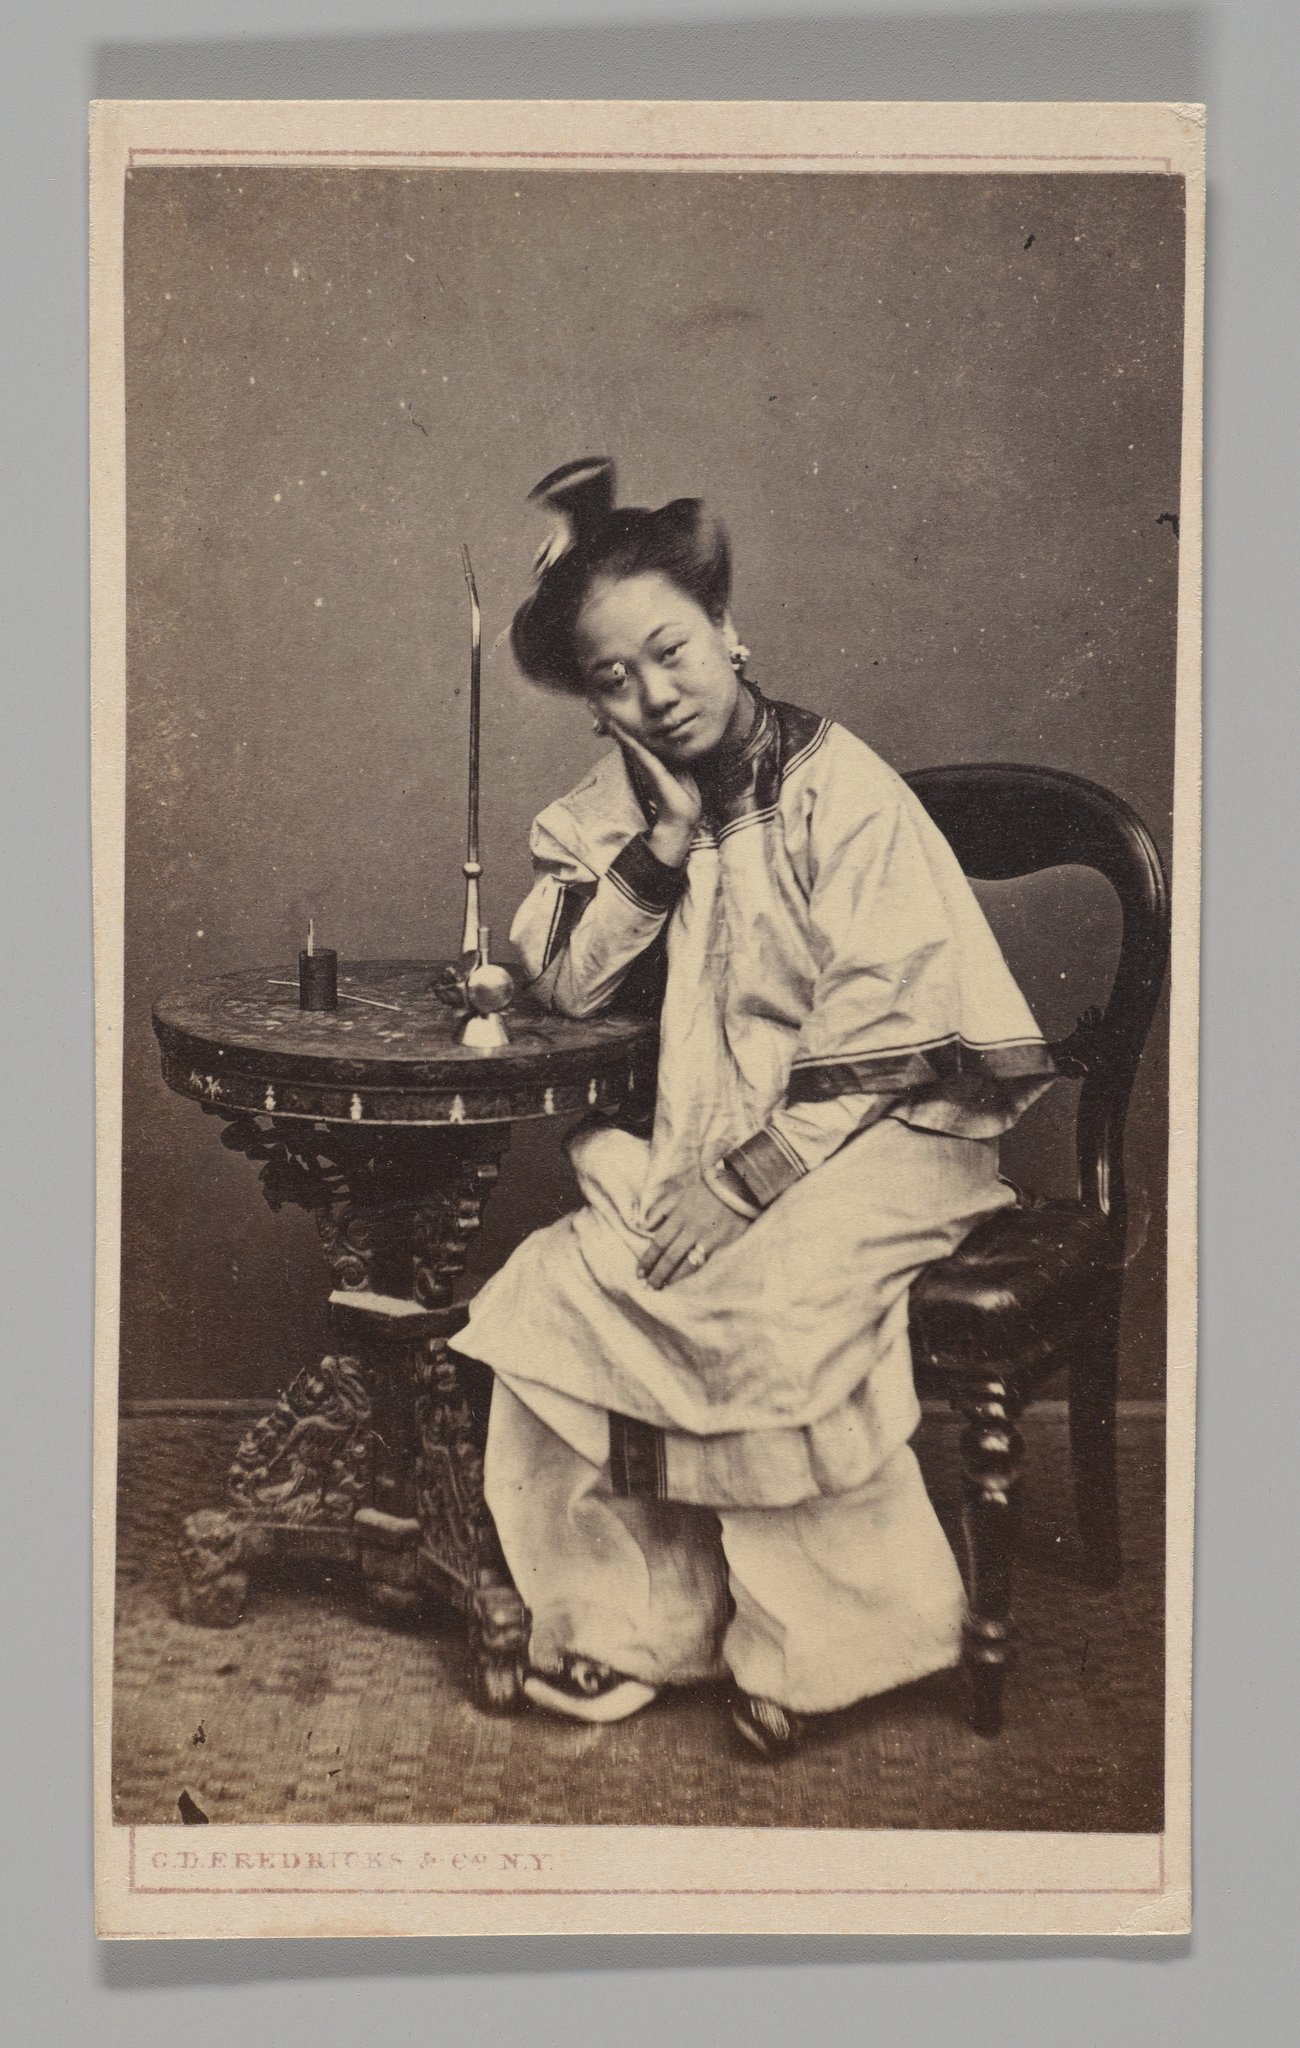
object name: carte de visite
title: [Studio Portrait: Woman Seated Beside a Table Leaning on Elbow]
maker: c.d. fredricks & co.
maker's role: publisher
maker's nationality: american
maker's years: 1850-1880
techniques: albumen silver print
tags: portraits,women